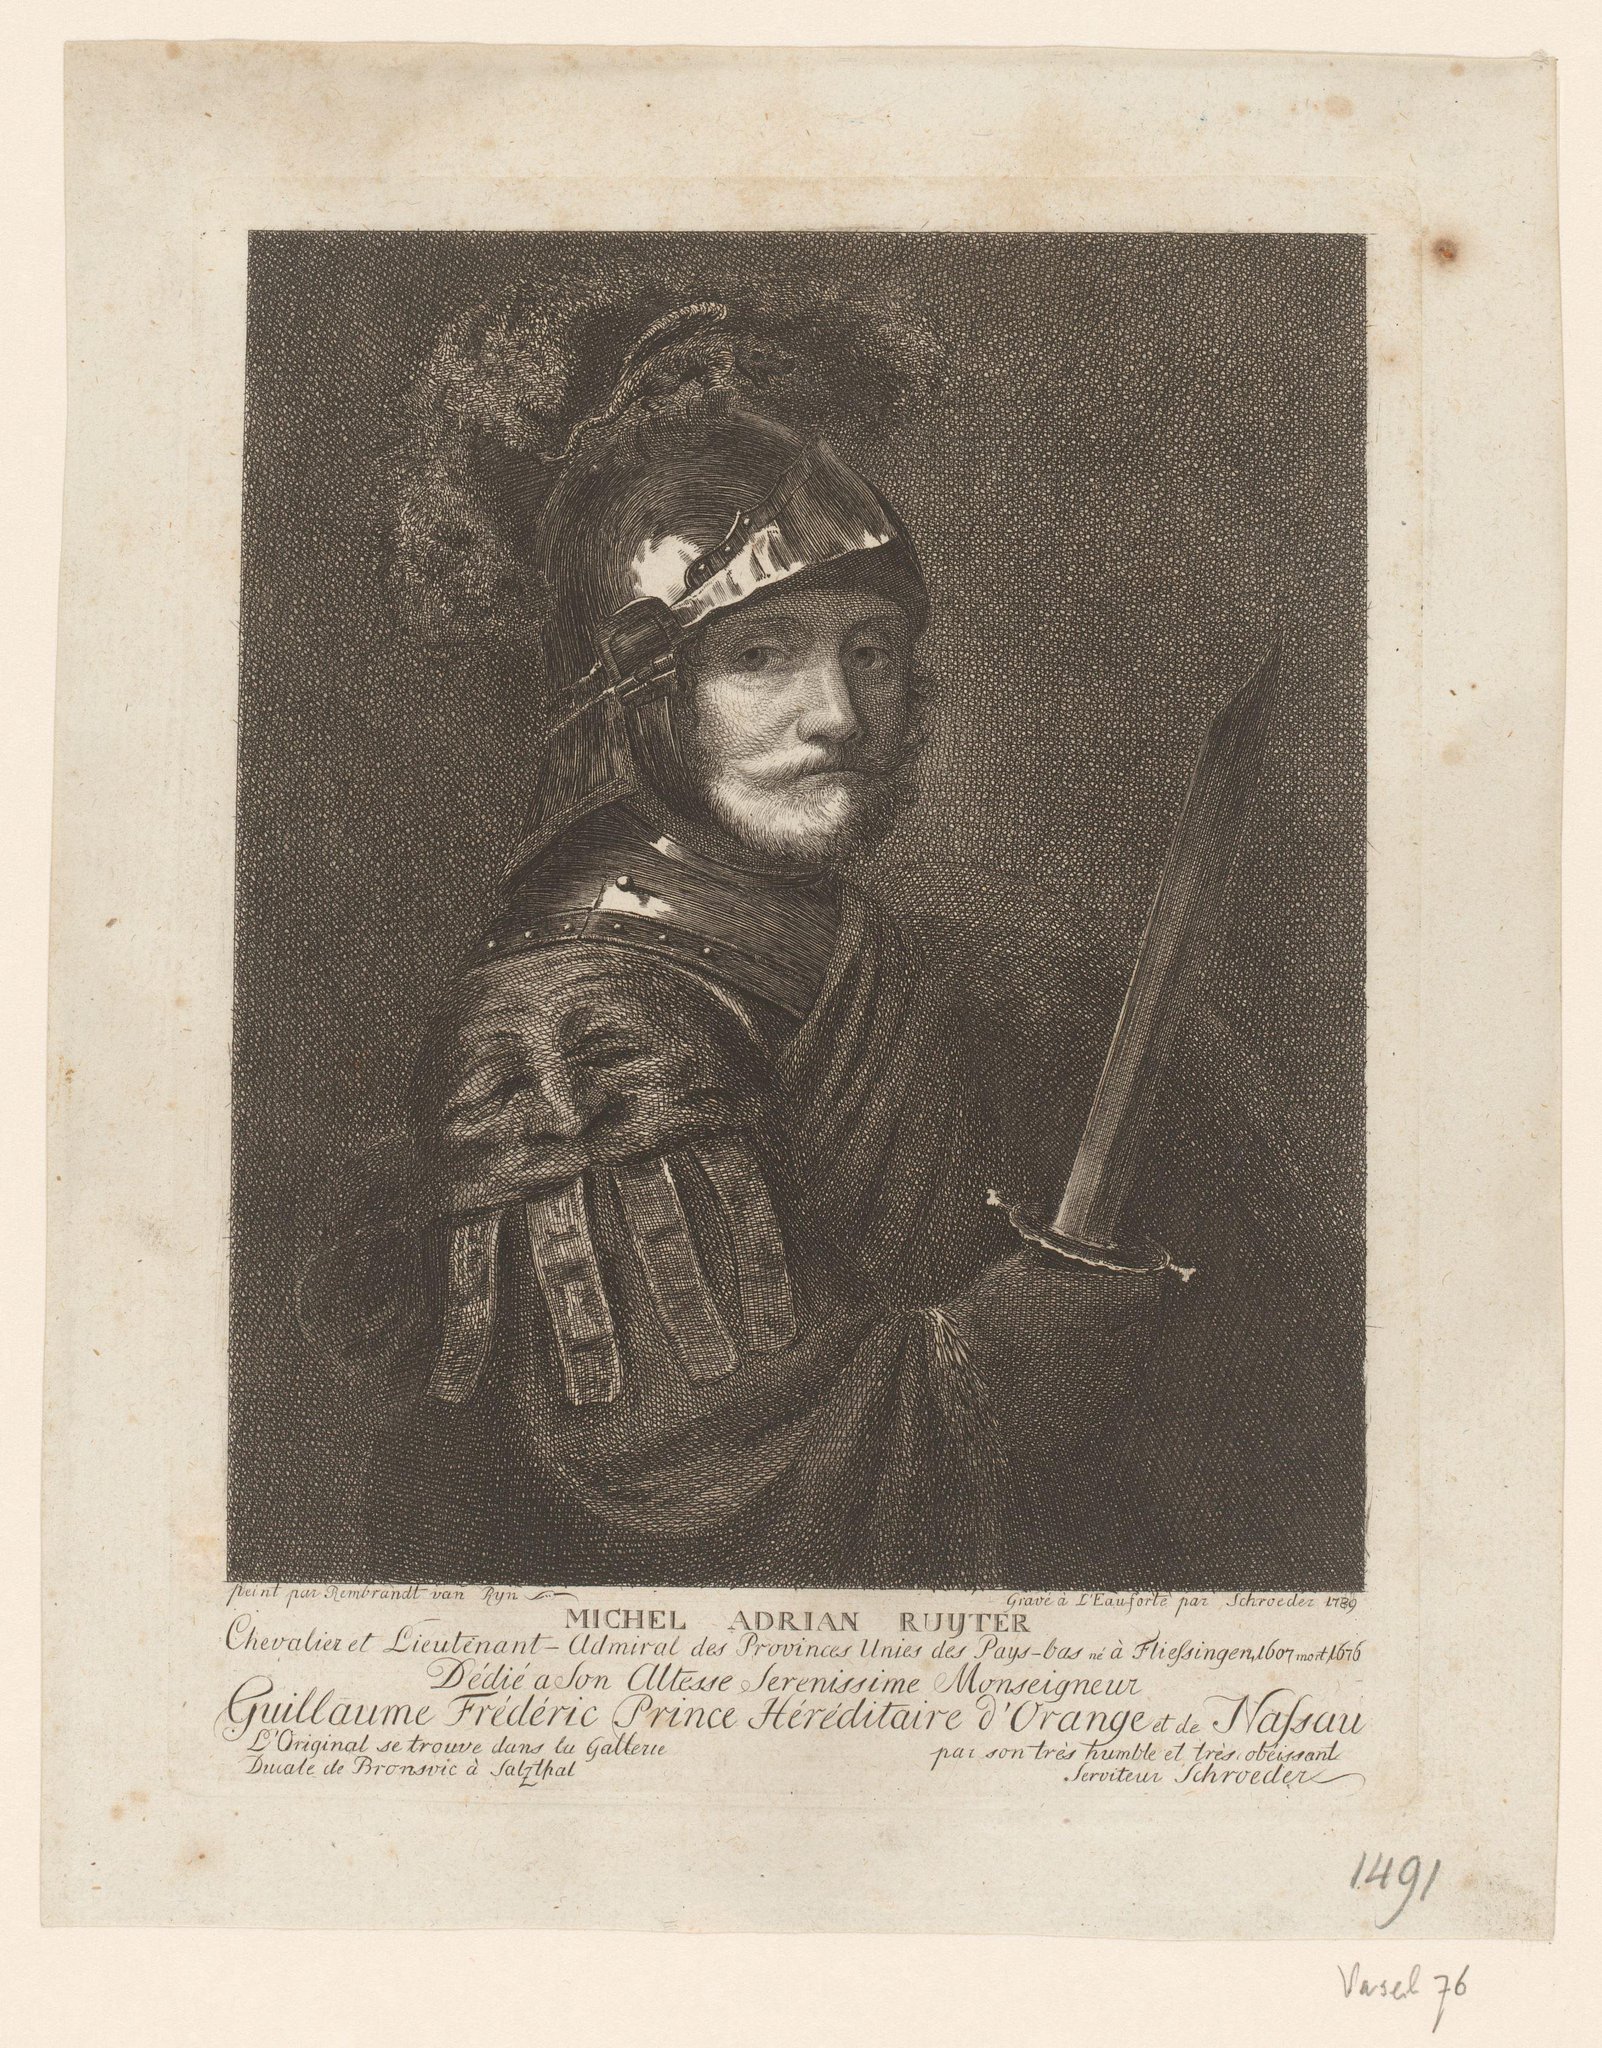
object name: print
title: Man met helm en zwaard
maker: karl schröder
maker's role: print maker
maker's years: 1760-1844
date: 1789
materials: paper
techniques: etching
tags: armour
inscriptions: collector's mark: Lugt 2228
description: Volgens onderschrift portret van Michiel de Ruyter.